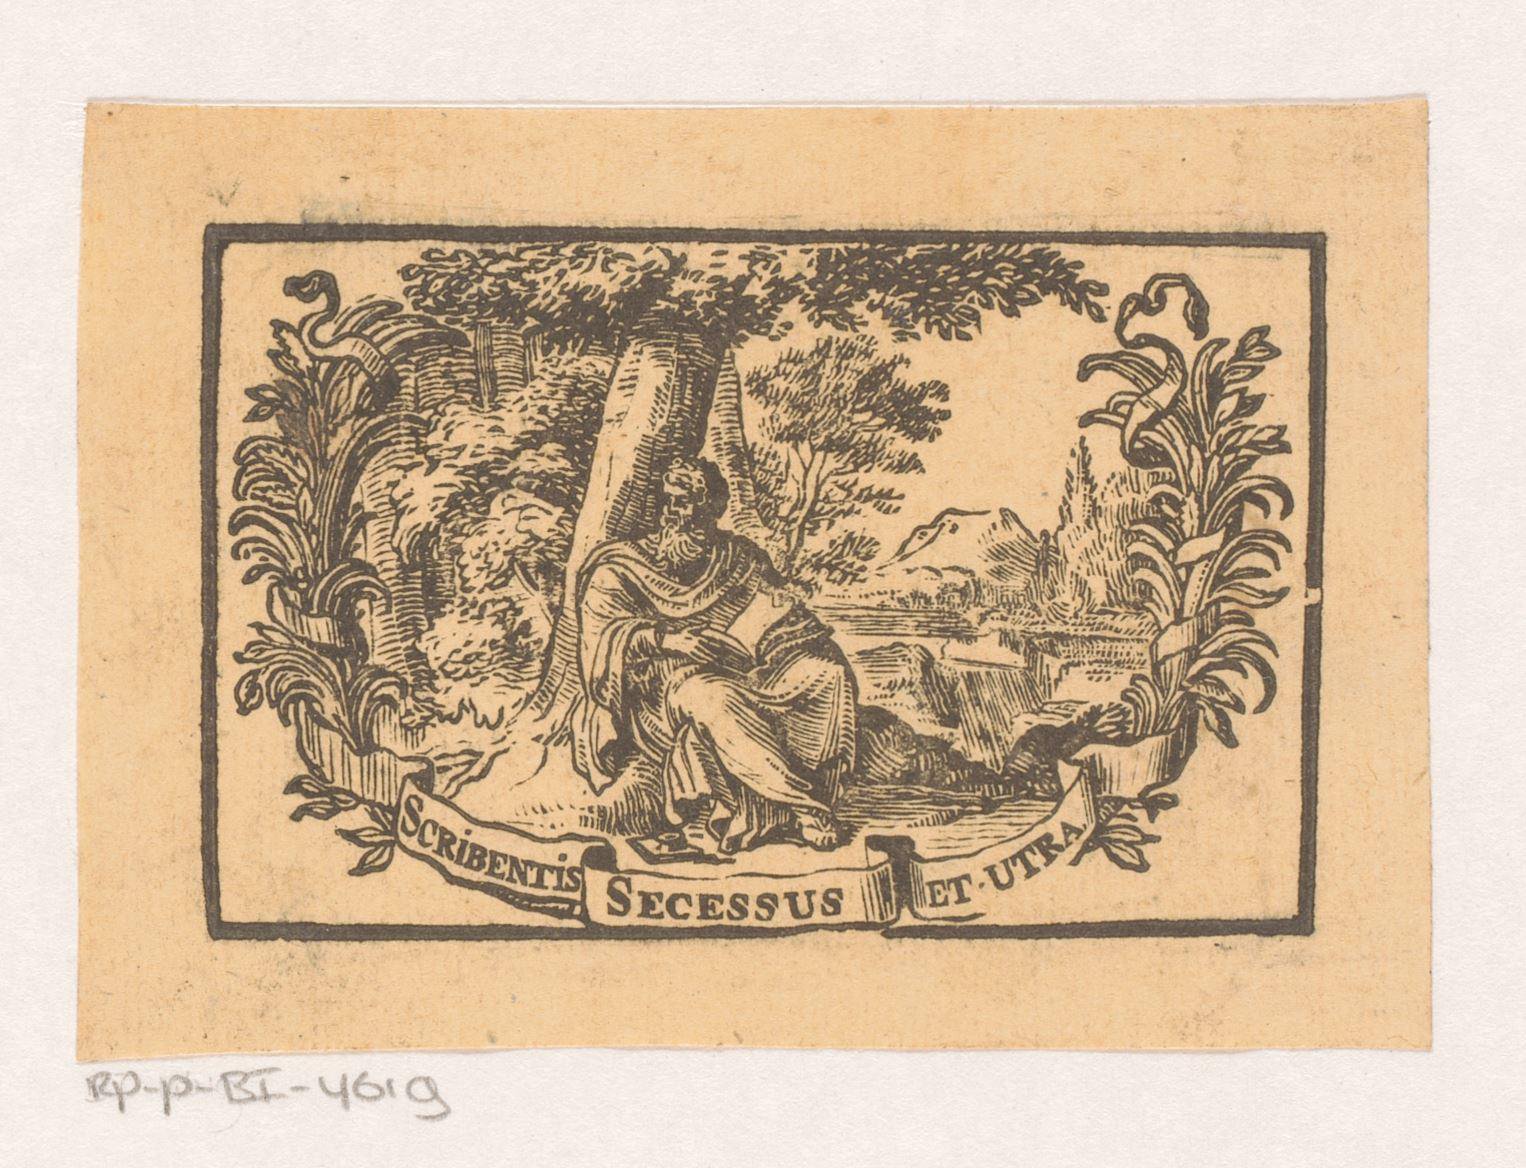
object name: print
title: Schrijver met een boek zittend tegen een boom bij het water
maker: Anonymous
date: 1600-1699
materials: paper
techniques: woodcut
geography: netherlands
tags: writer, poet, author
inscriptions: collector's mark: Lugt 240